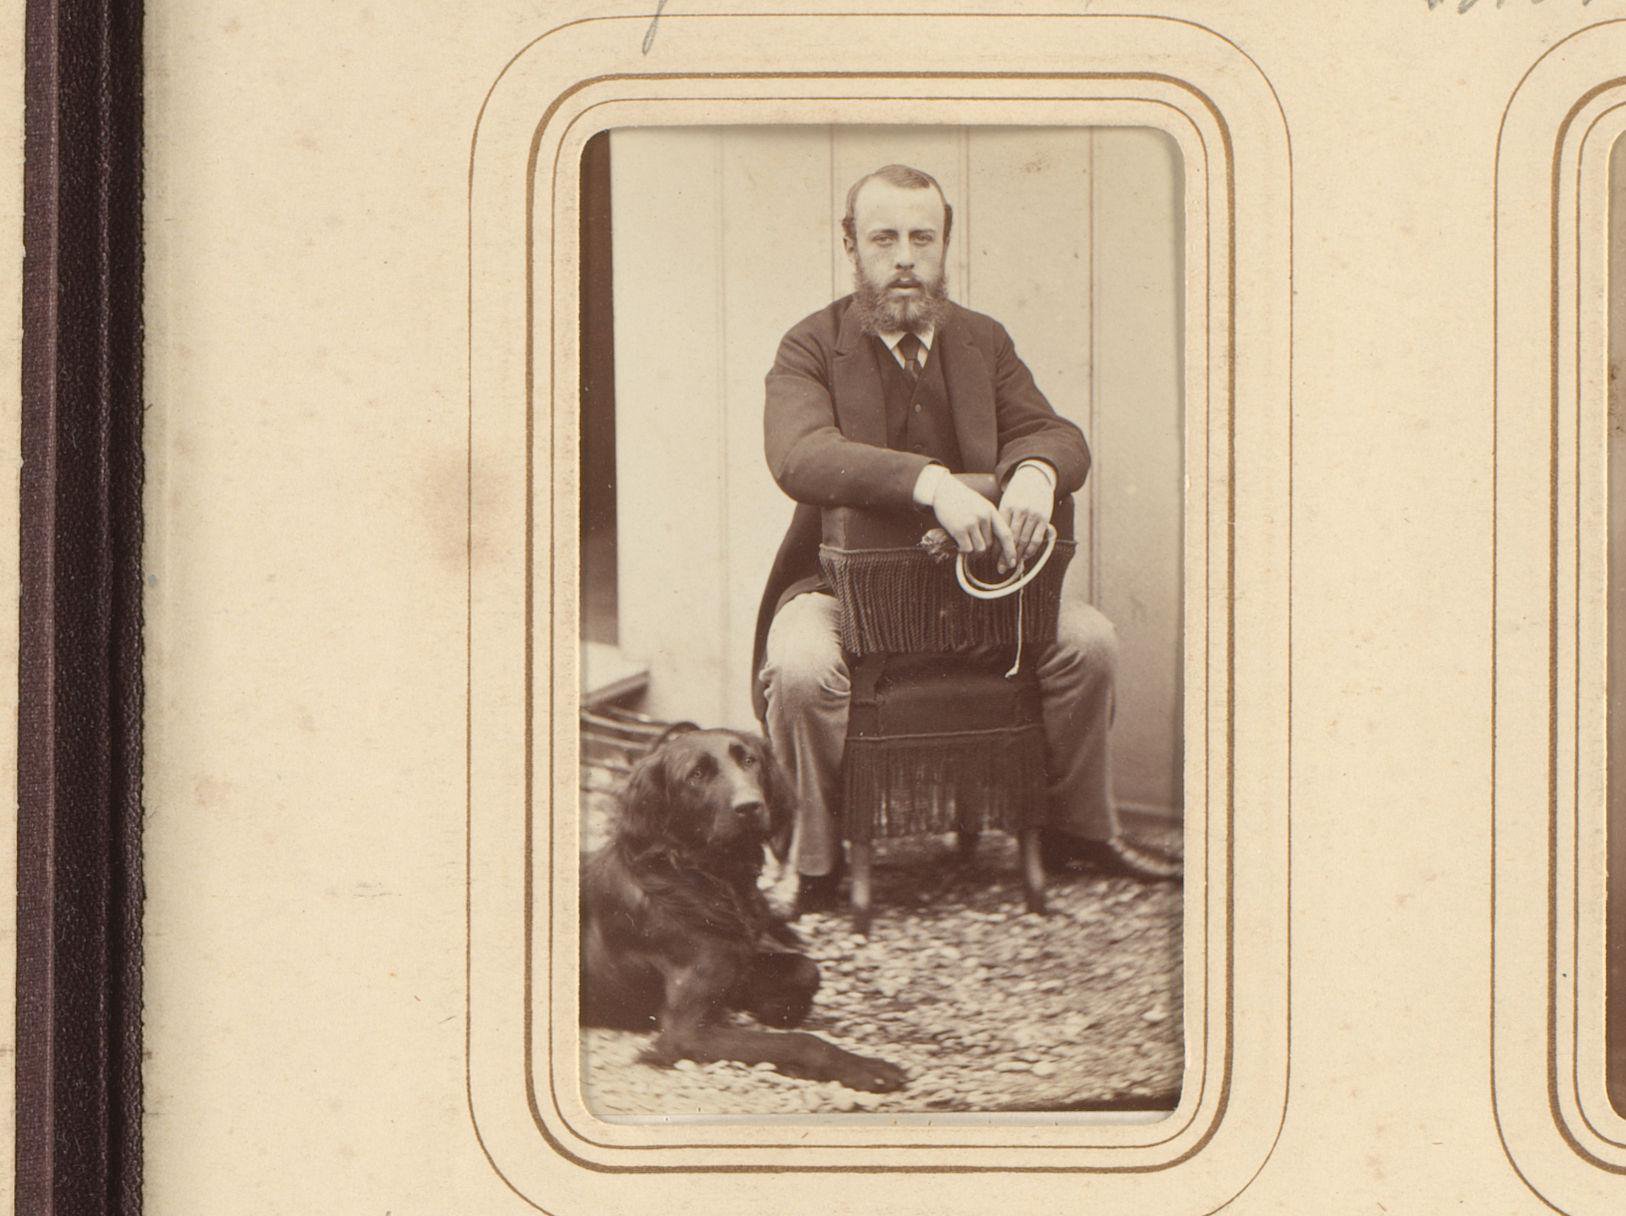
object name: album leaf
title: Portret van een man met hond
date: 1860-1880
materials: cardboard, photographic support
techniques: albumen print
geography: netherlands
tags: adult man, dog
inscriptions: inscription: ‘Photogr. Atelier / Wegner & Mottu / Kalverstraat / over den Heyligenweg, D. 26. /Amsterdam / Leydsche Straatweg / Buiten Cathrynen. / Utrecht’